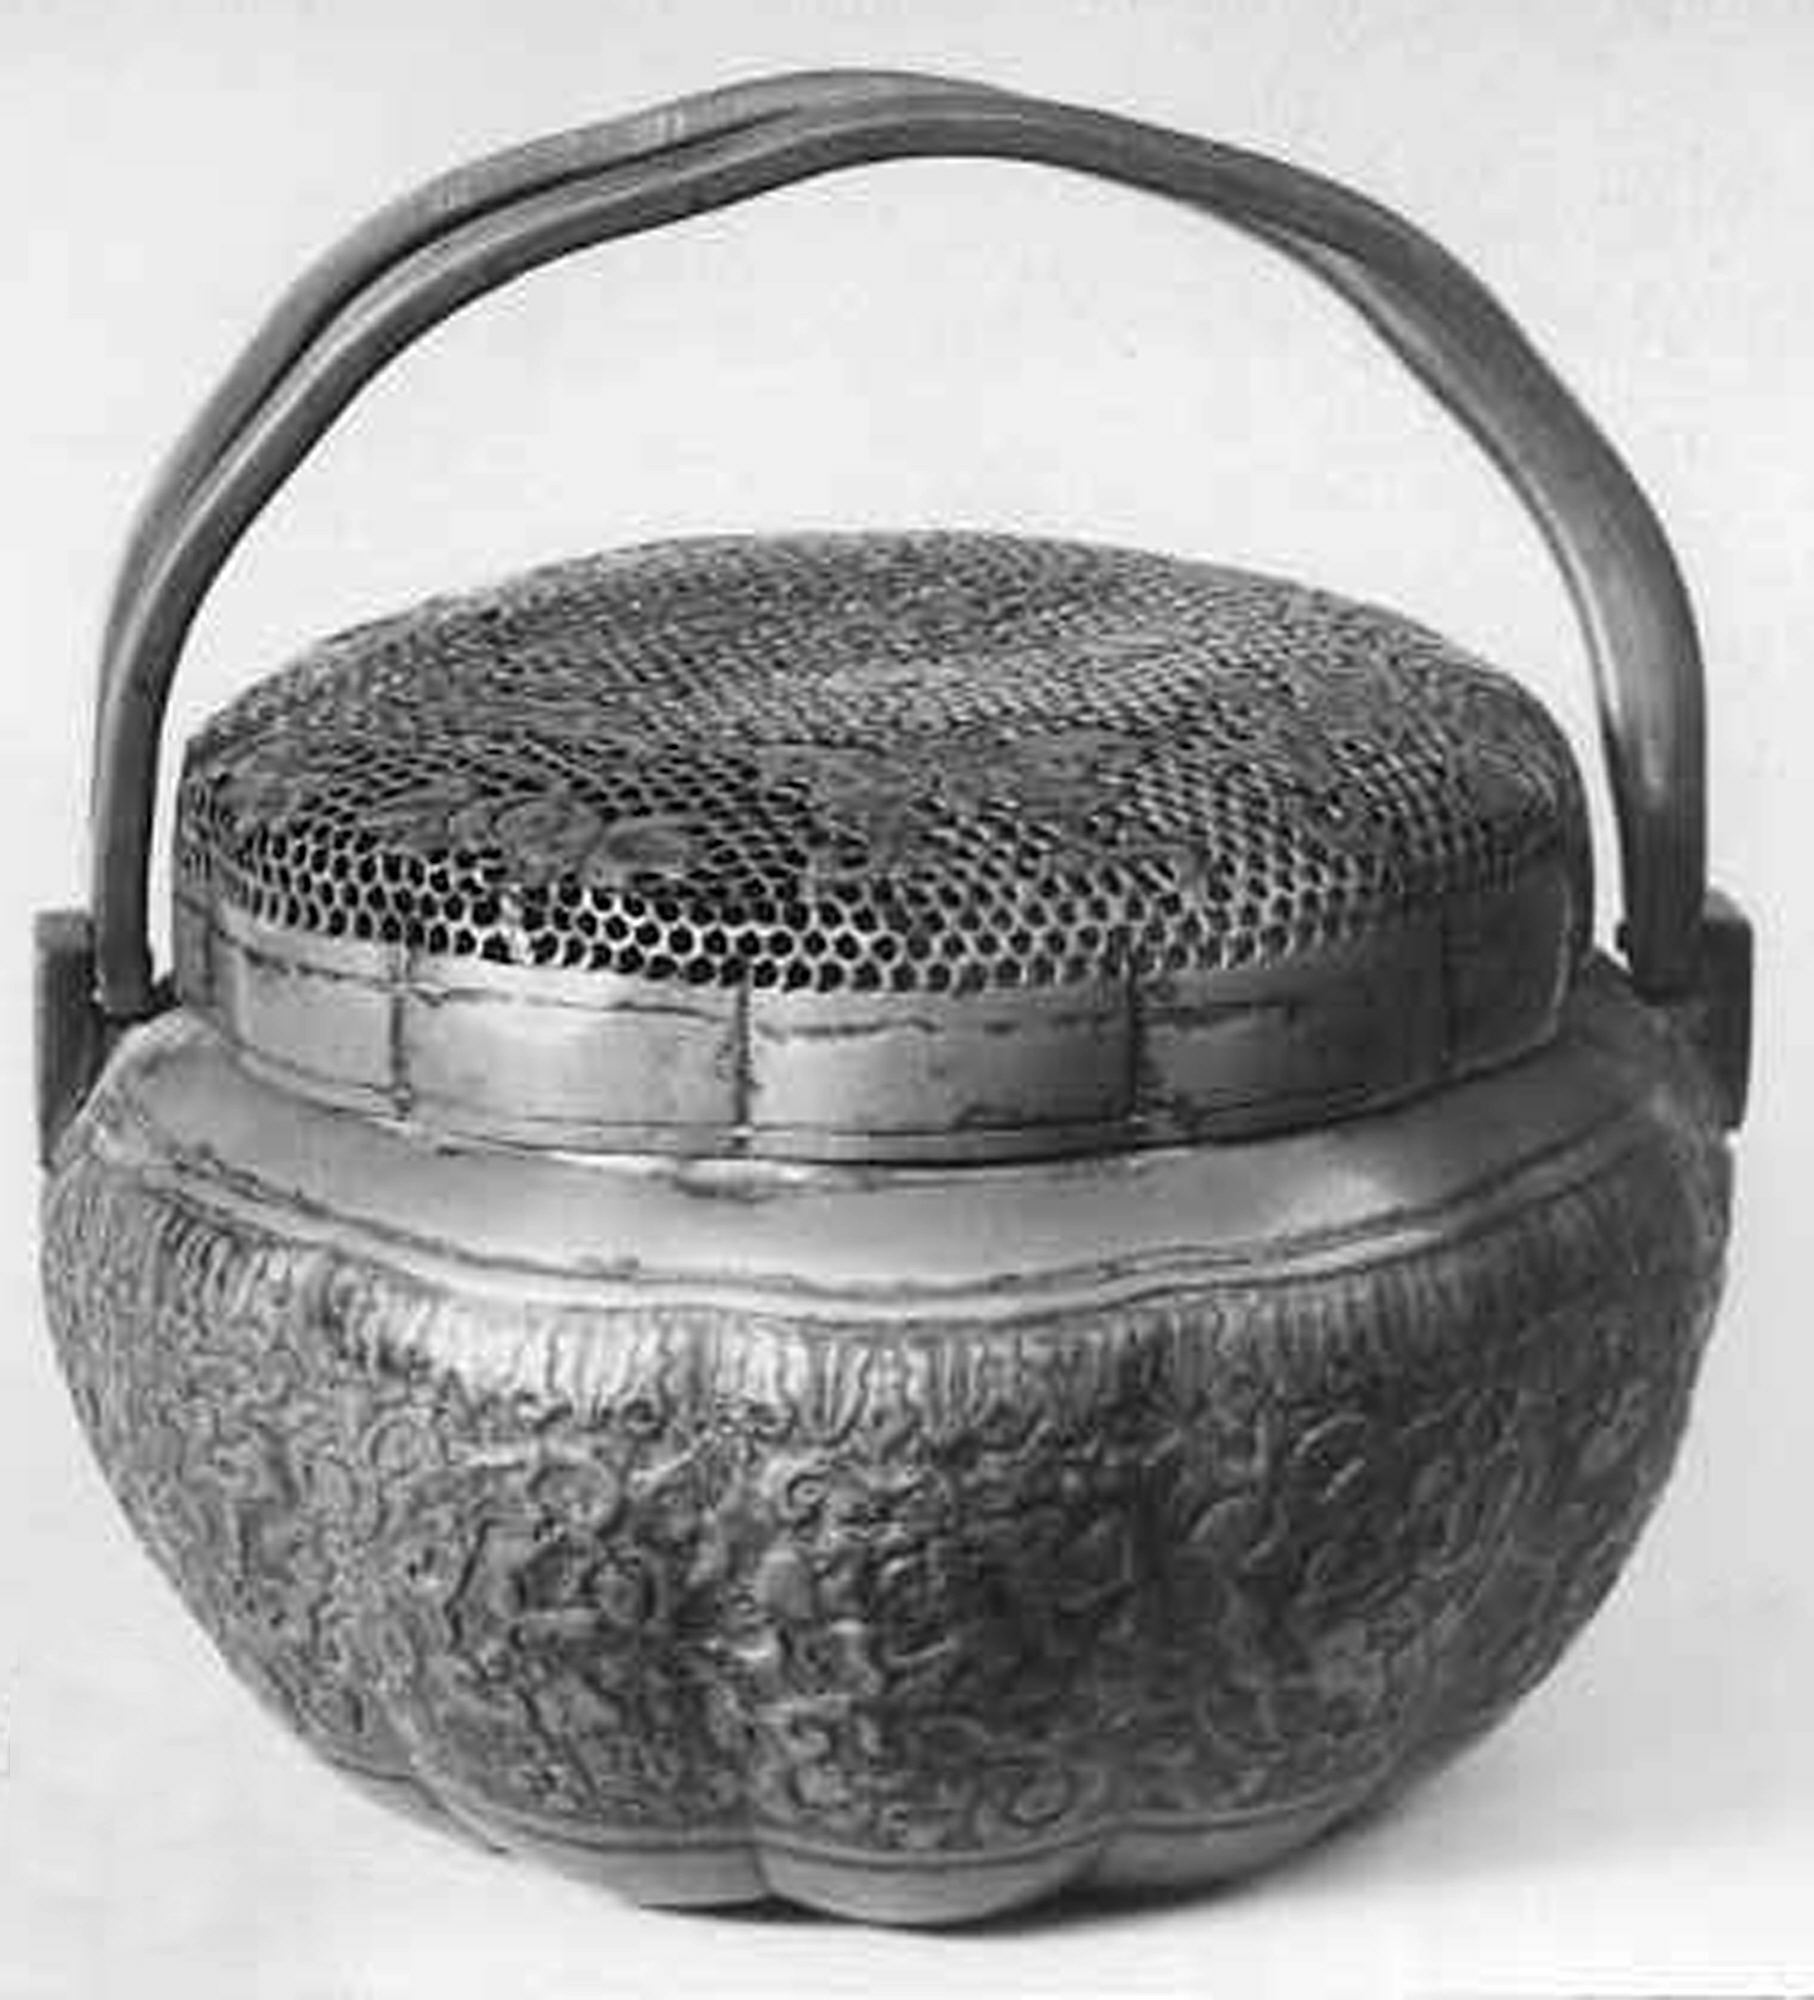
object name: incense burner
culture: japanese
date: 1701-1800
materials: bronze